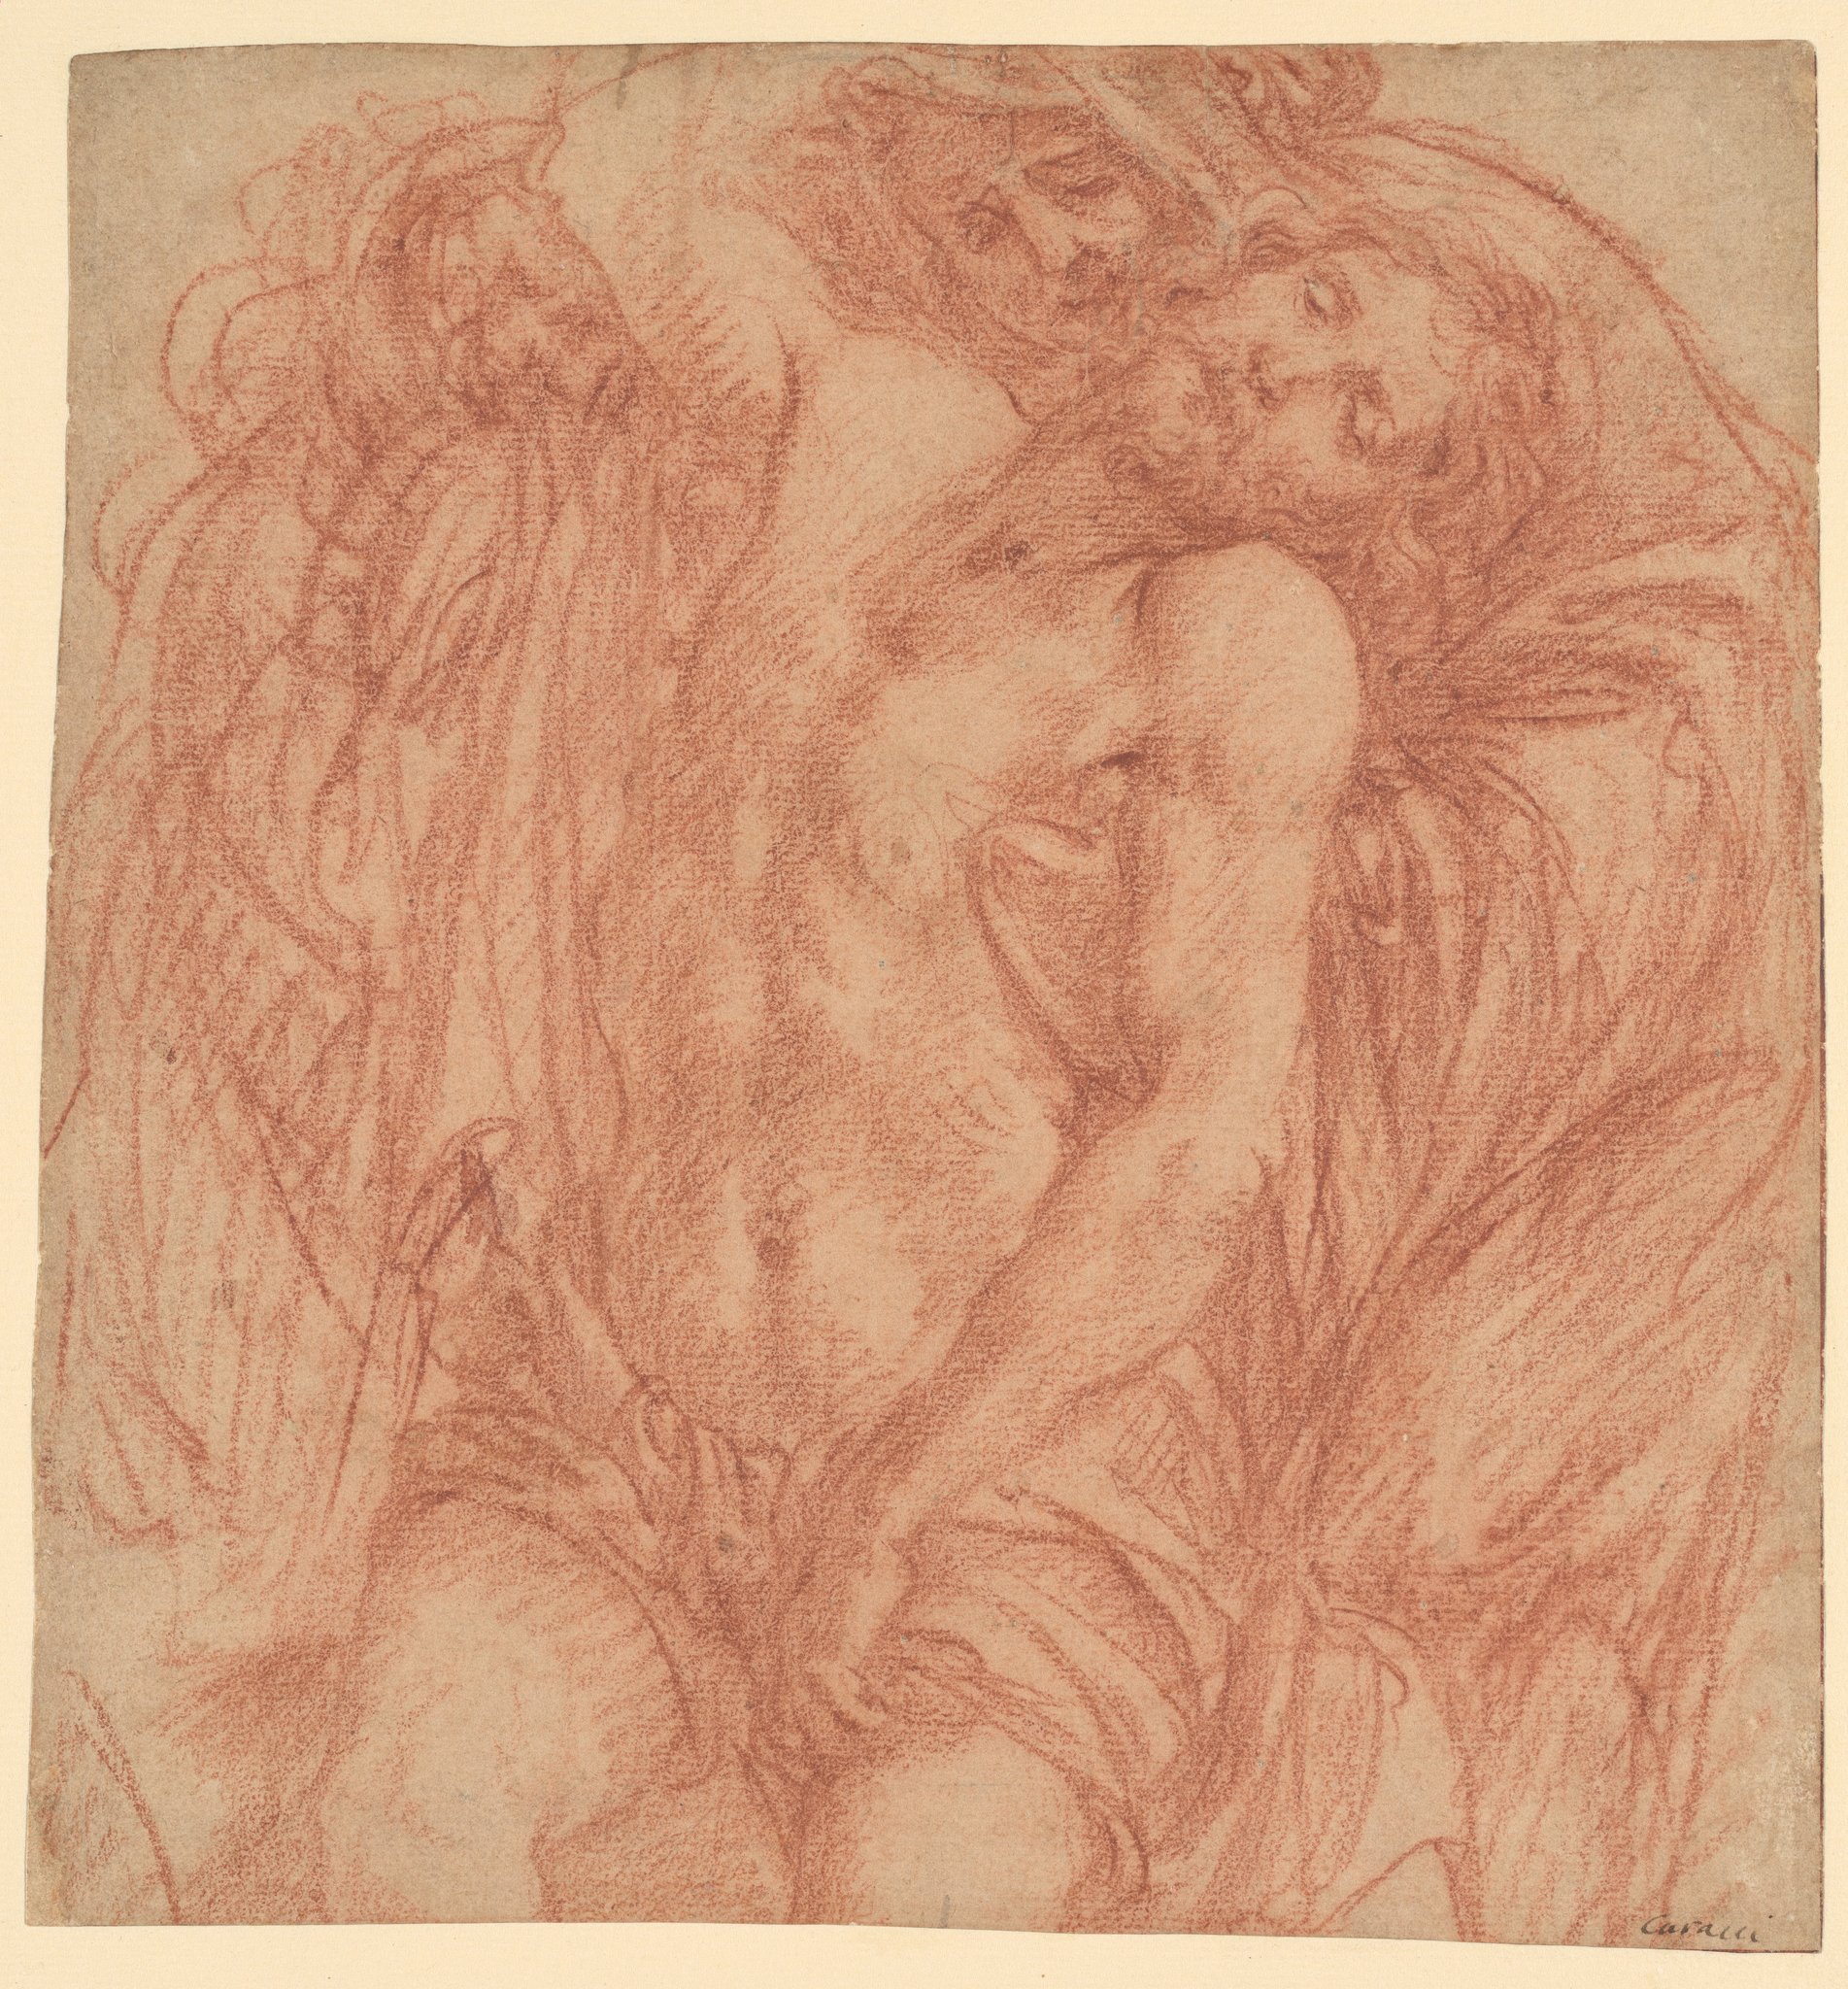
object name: drawing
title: Study for a Pietà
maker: fabrizio boschi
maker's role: artist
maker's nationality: italian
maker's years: 1572-1642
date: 1620-1629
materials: chalk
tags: christ,virgin mary